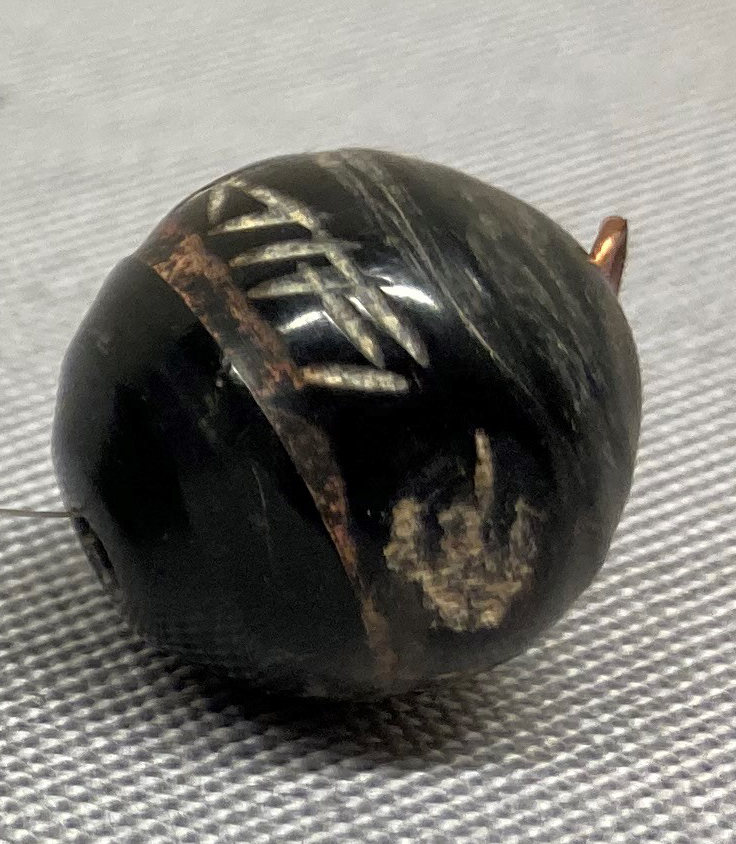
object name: bead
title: Stone Beads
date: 701-1200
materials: stone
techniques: incising, painting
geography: iran